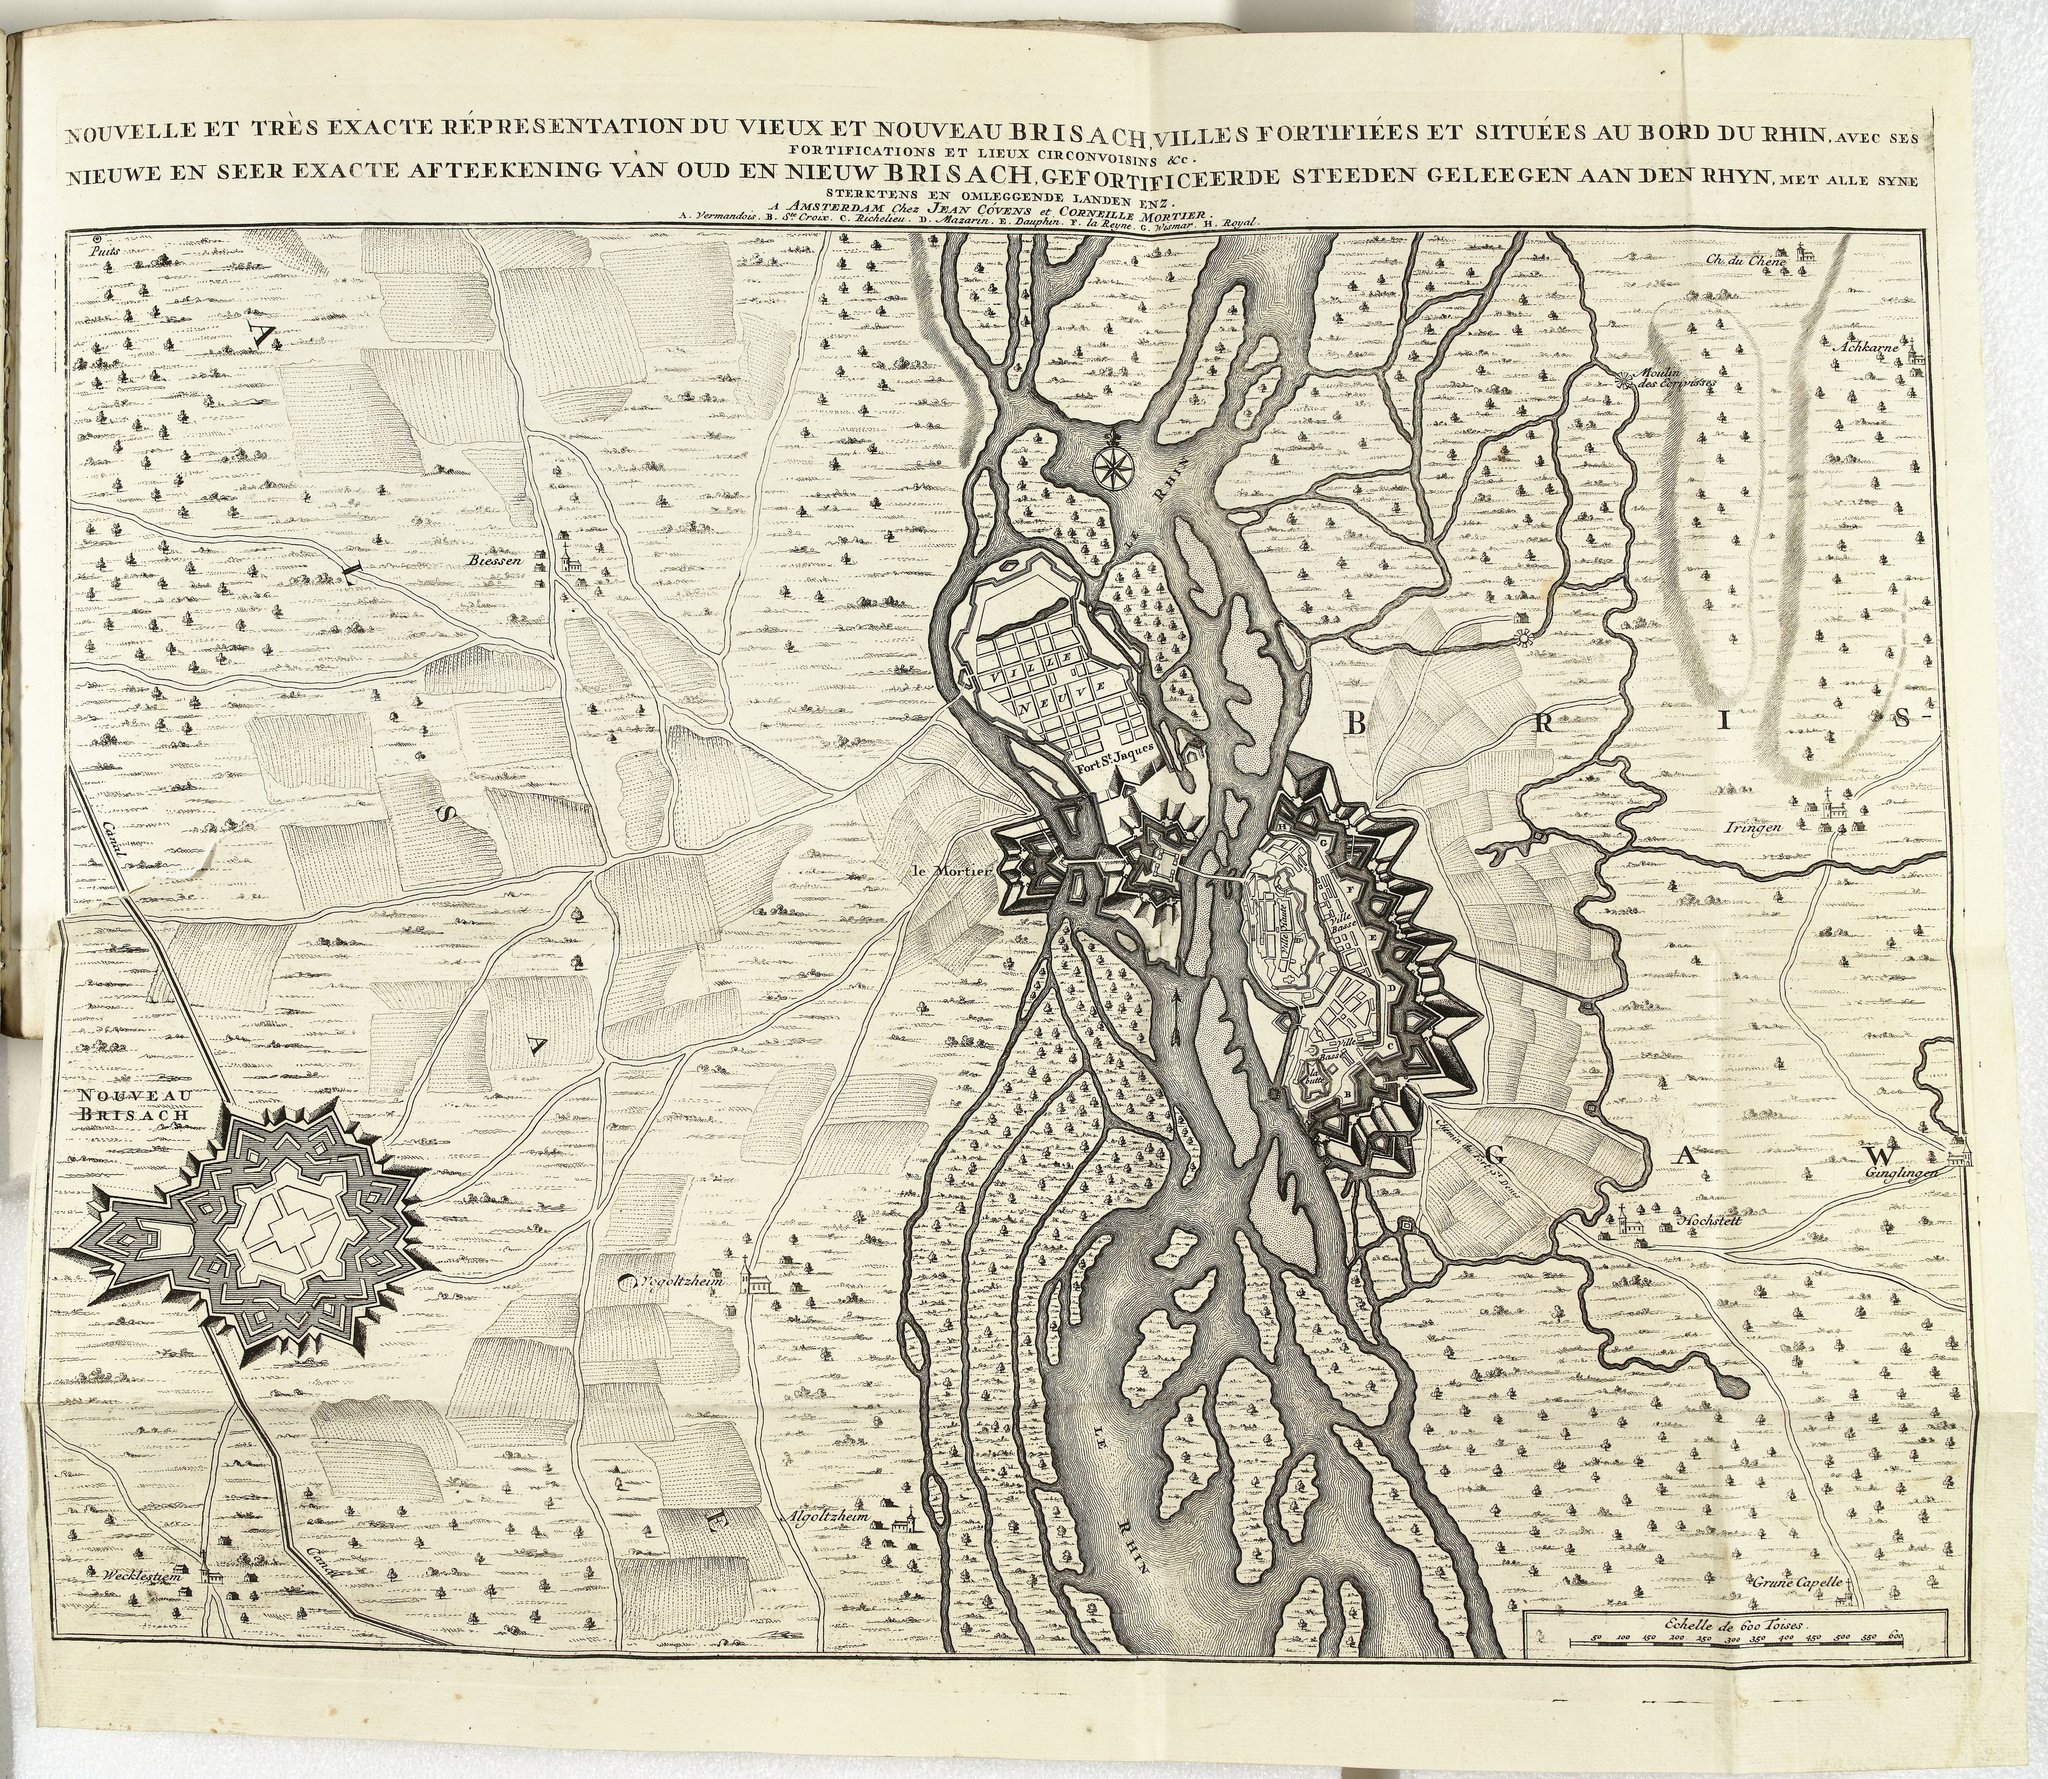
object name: map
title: Nieuwe en seer exacte afteekening van oud en nieuw Brisach, gefortificeerde steeden geleegen aan den Rhyn (...)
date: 1702-1703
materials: paper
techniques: etching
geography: amsterdam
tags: fortress, maps of cities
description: Grote kaart met plattegronden van oud en nieuw Breisach, gelegen aan de Rijn. Plaat nr. 95 in het prentwerk bestaande in totaal uit 276 genummerde platen van vermaarde sterke steden en vestingen in het kader van de Spaanse Successieoorlog. Voor het merendeel zijn deze platen gekopieerd naar de anonieme Franse platen: in Les forces de l'Europe en in: Le theatre de la guerre, dans les Pays-Bas, beide oorspronkelijk uitgegeven door Nicolas de Fer te Parijs (1693-1697) in het kader van de Negenjarige Oorlog. Opschriften in de plaat in het Frans.